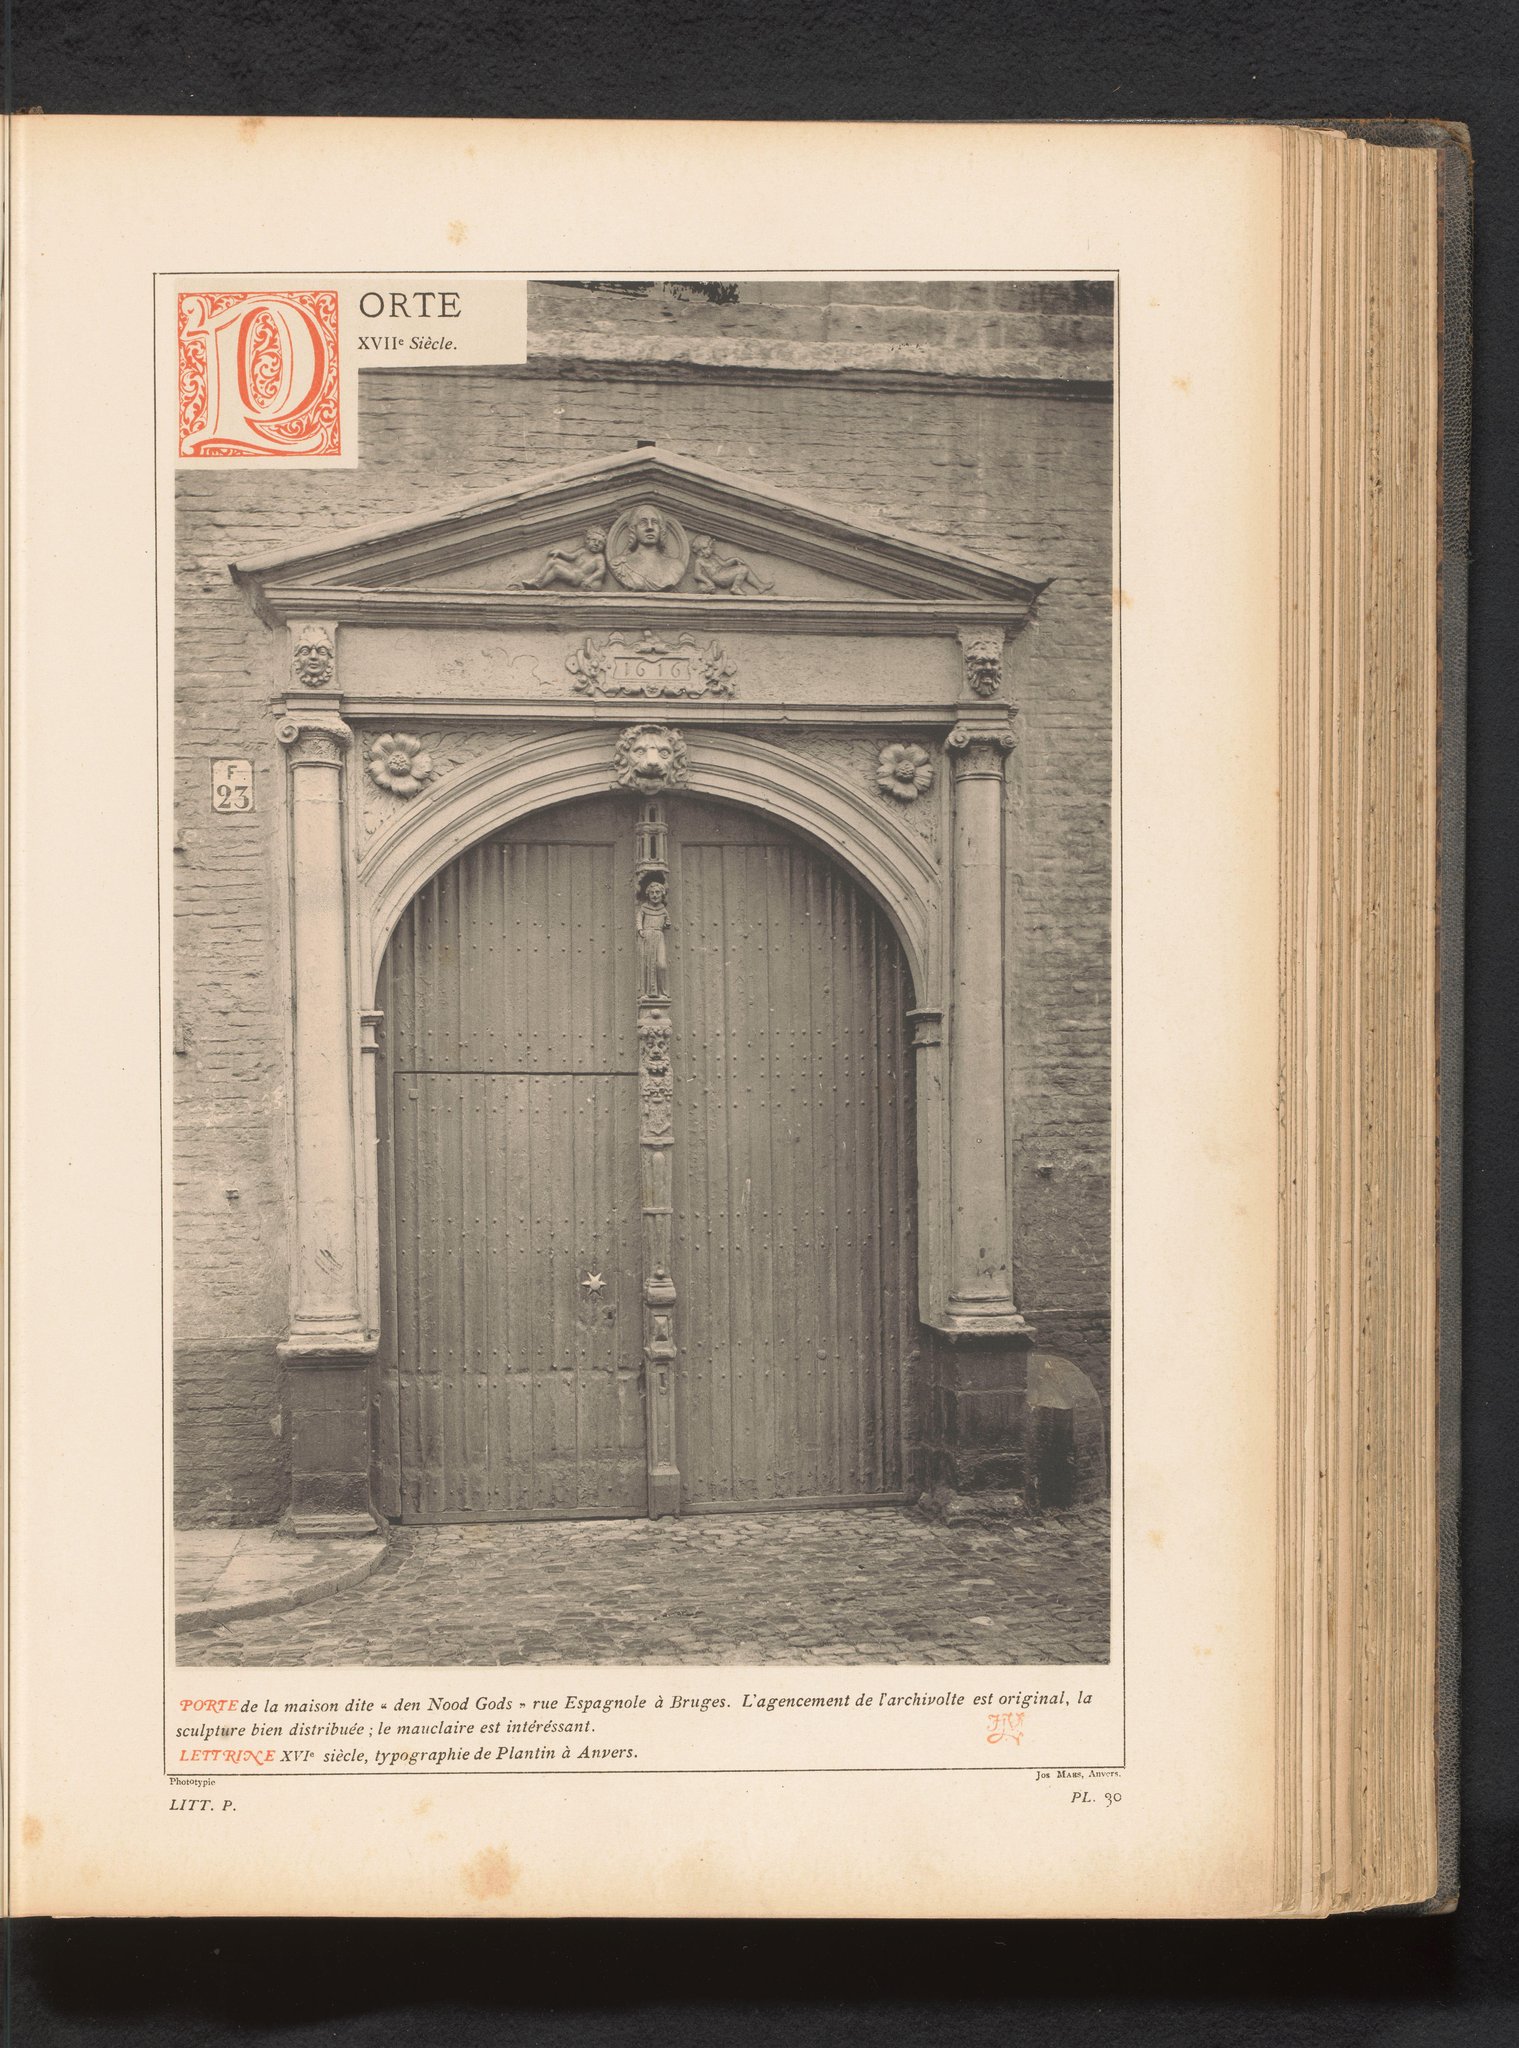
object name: page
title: Porte, XVIIe Siècle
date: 1876-1881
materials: paper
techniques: photograph, photolithography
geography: antwerp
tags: door, bruges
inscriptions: monogram: ‘JJvY’, inscription: ‘PORTE de la (...)’, inscription: ‘LITT. P. - PL. 30.’